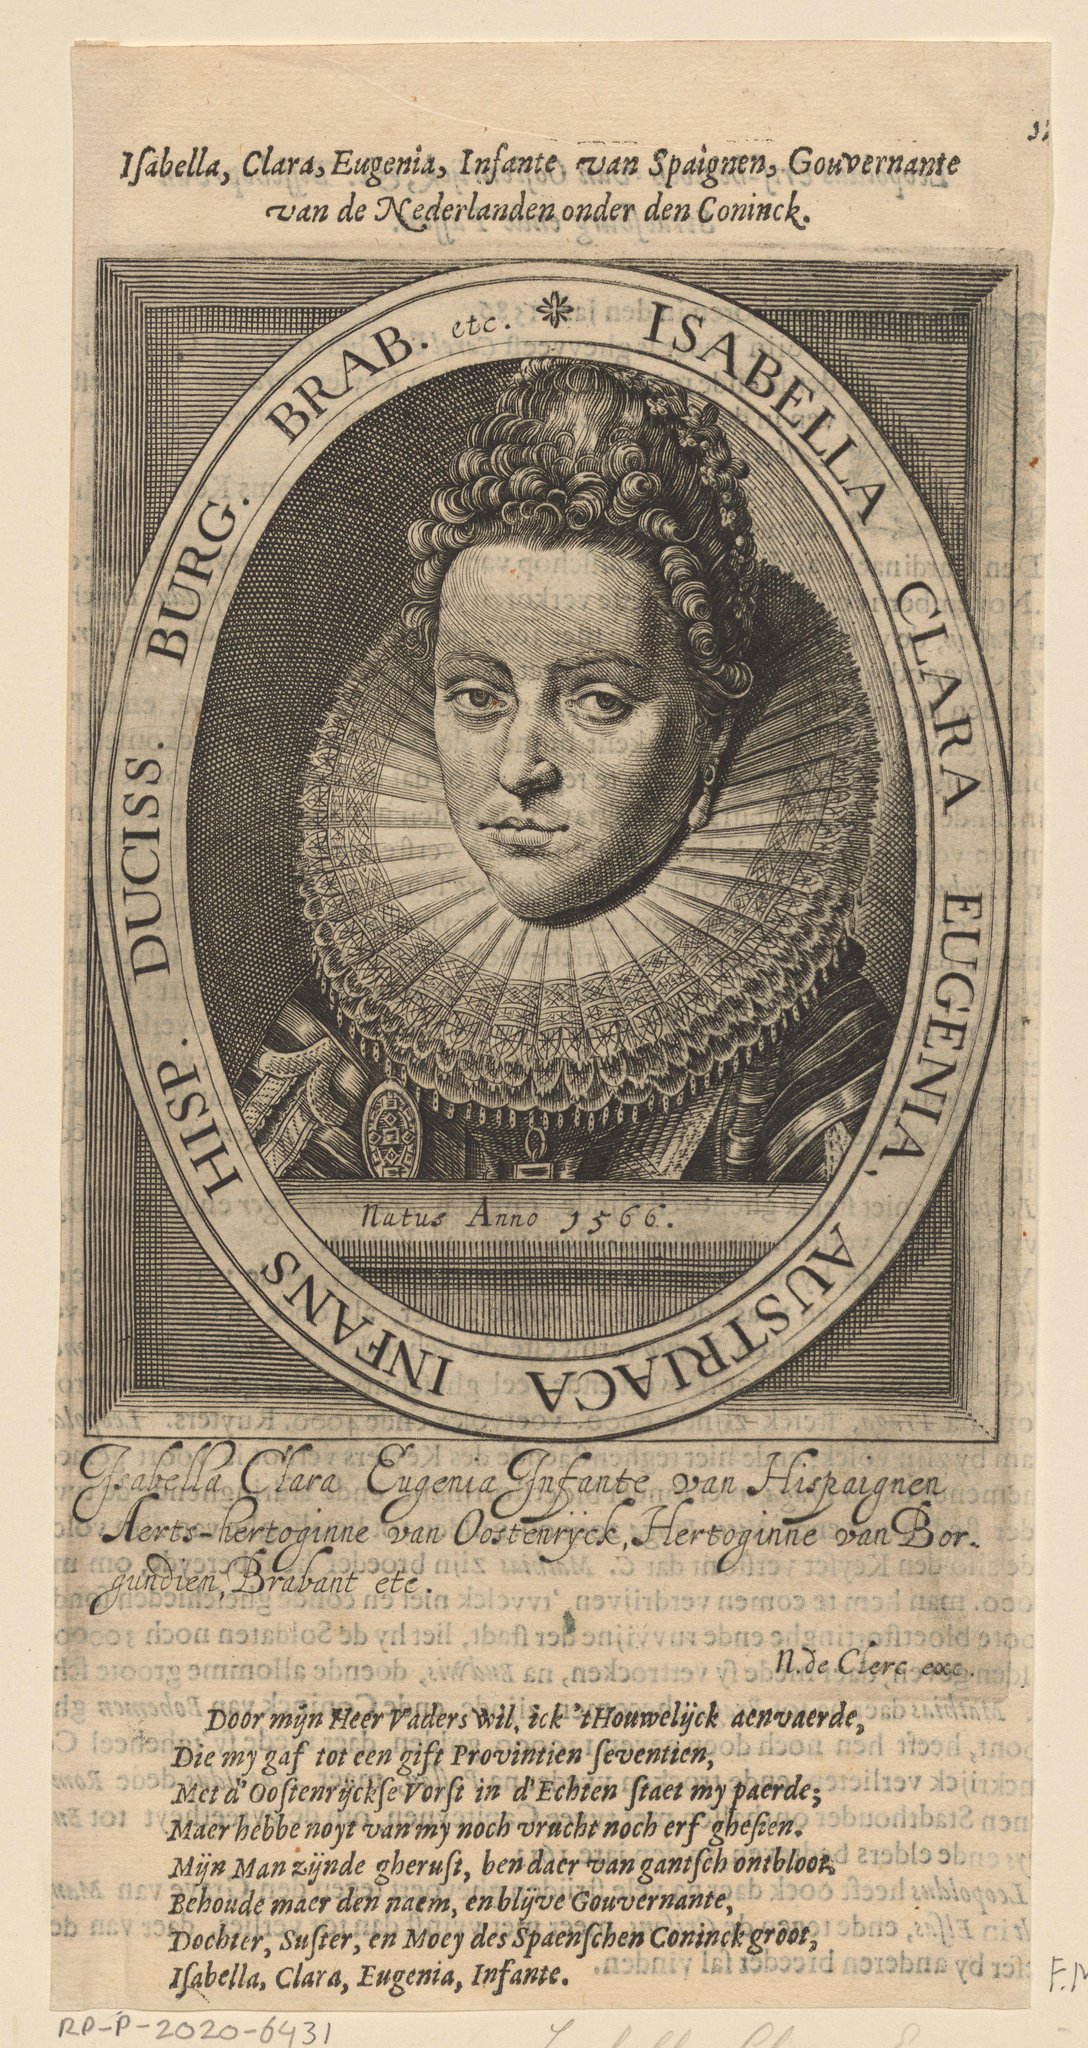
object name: print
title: Portret van Isabella Clara Eugenia, infante van Spanje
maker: Anonymous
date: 1625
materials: paper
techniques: engraving, letterpress printing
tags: infante van spanje isabella clara eugenia, historical persons - bb - woman, ruler, sovereign - bb - female ruler, neck-gear: collar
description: Op de prent staat het adres van uitgever Nicolaes de Clerck, maar mogelijk is de prent na zijn overlijden in 1623 uitgegeven. Prent uit: Princelyck Cabinet, Verthoonende T'leven Afcomste ende afbeeldingen der voornaemste Vorste (...). Delft: erven Nicolaes de Clerck, 1625, p. 57.